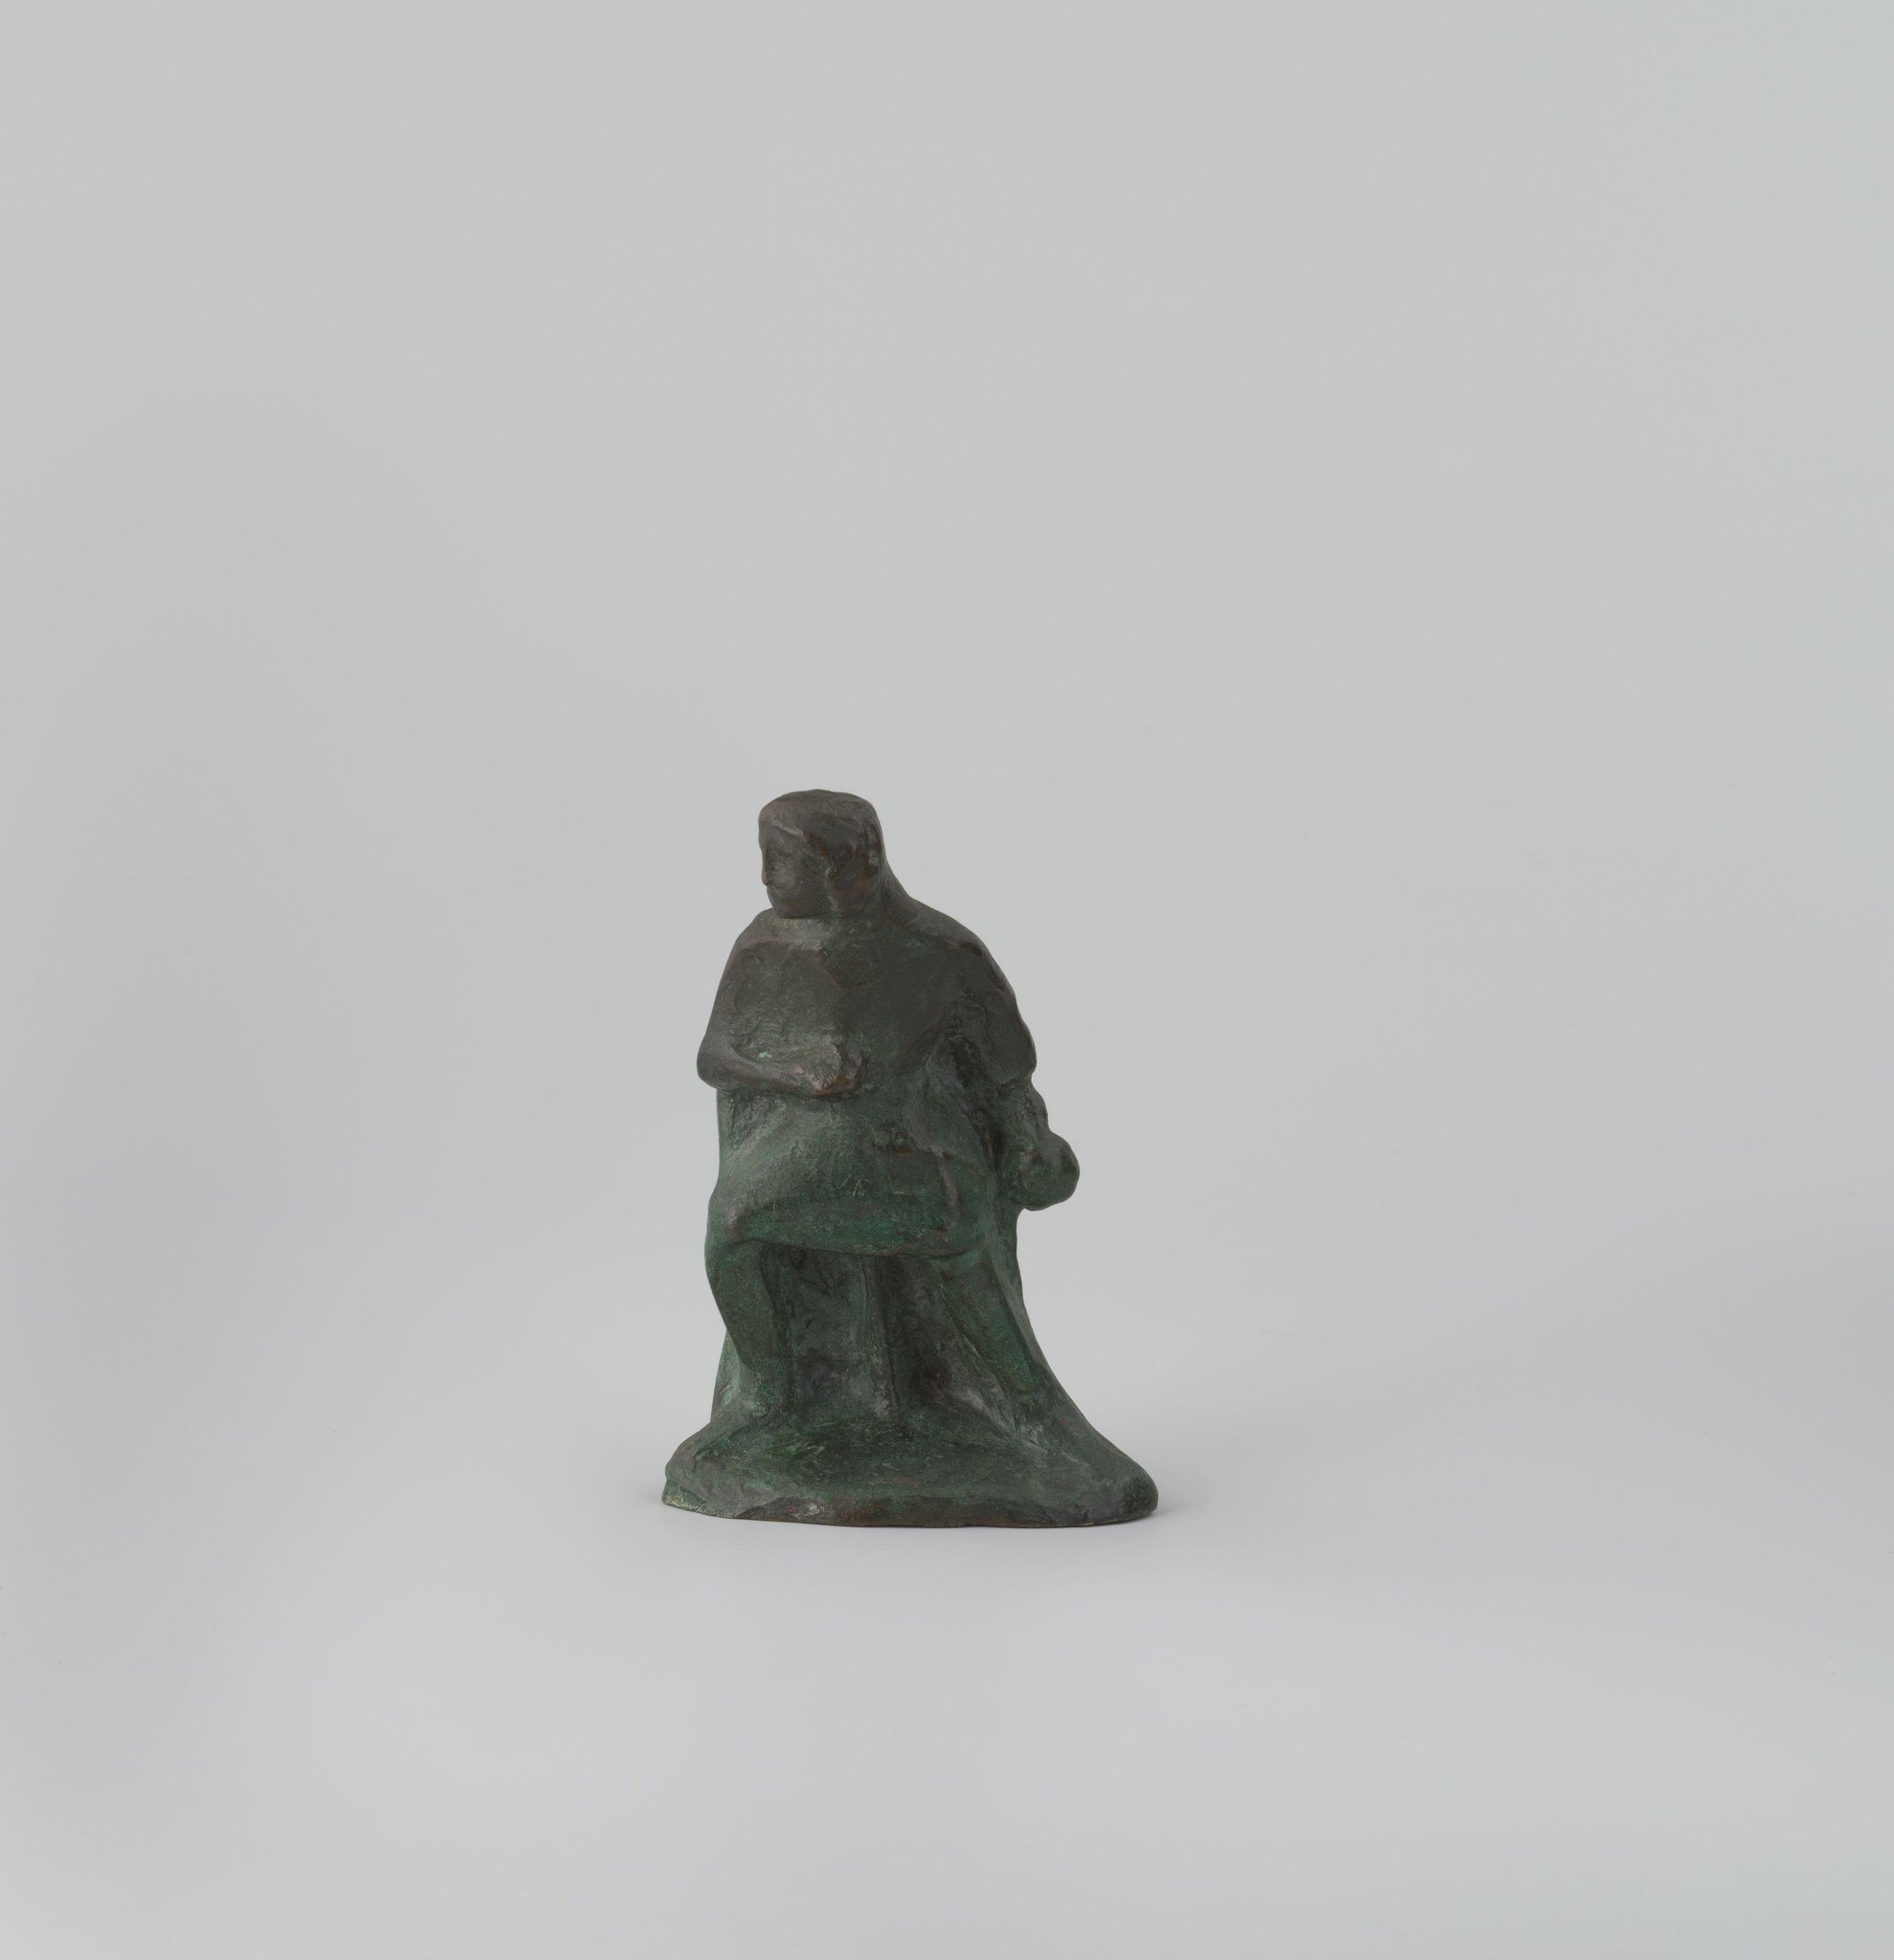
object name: chess piece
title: Pion 5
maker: saar de swart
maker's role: sculptor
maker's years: 1861-1951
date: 1923-1925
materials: bronze, oxide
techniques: casting, lost wax process, patinaed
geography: naples